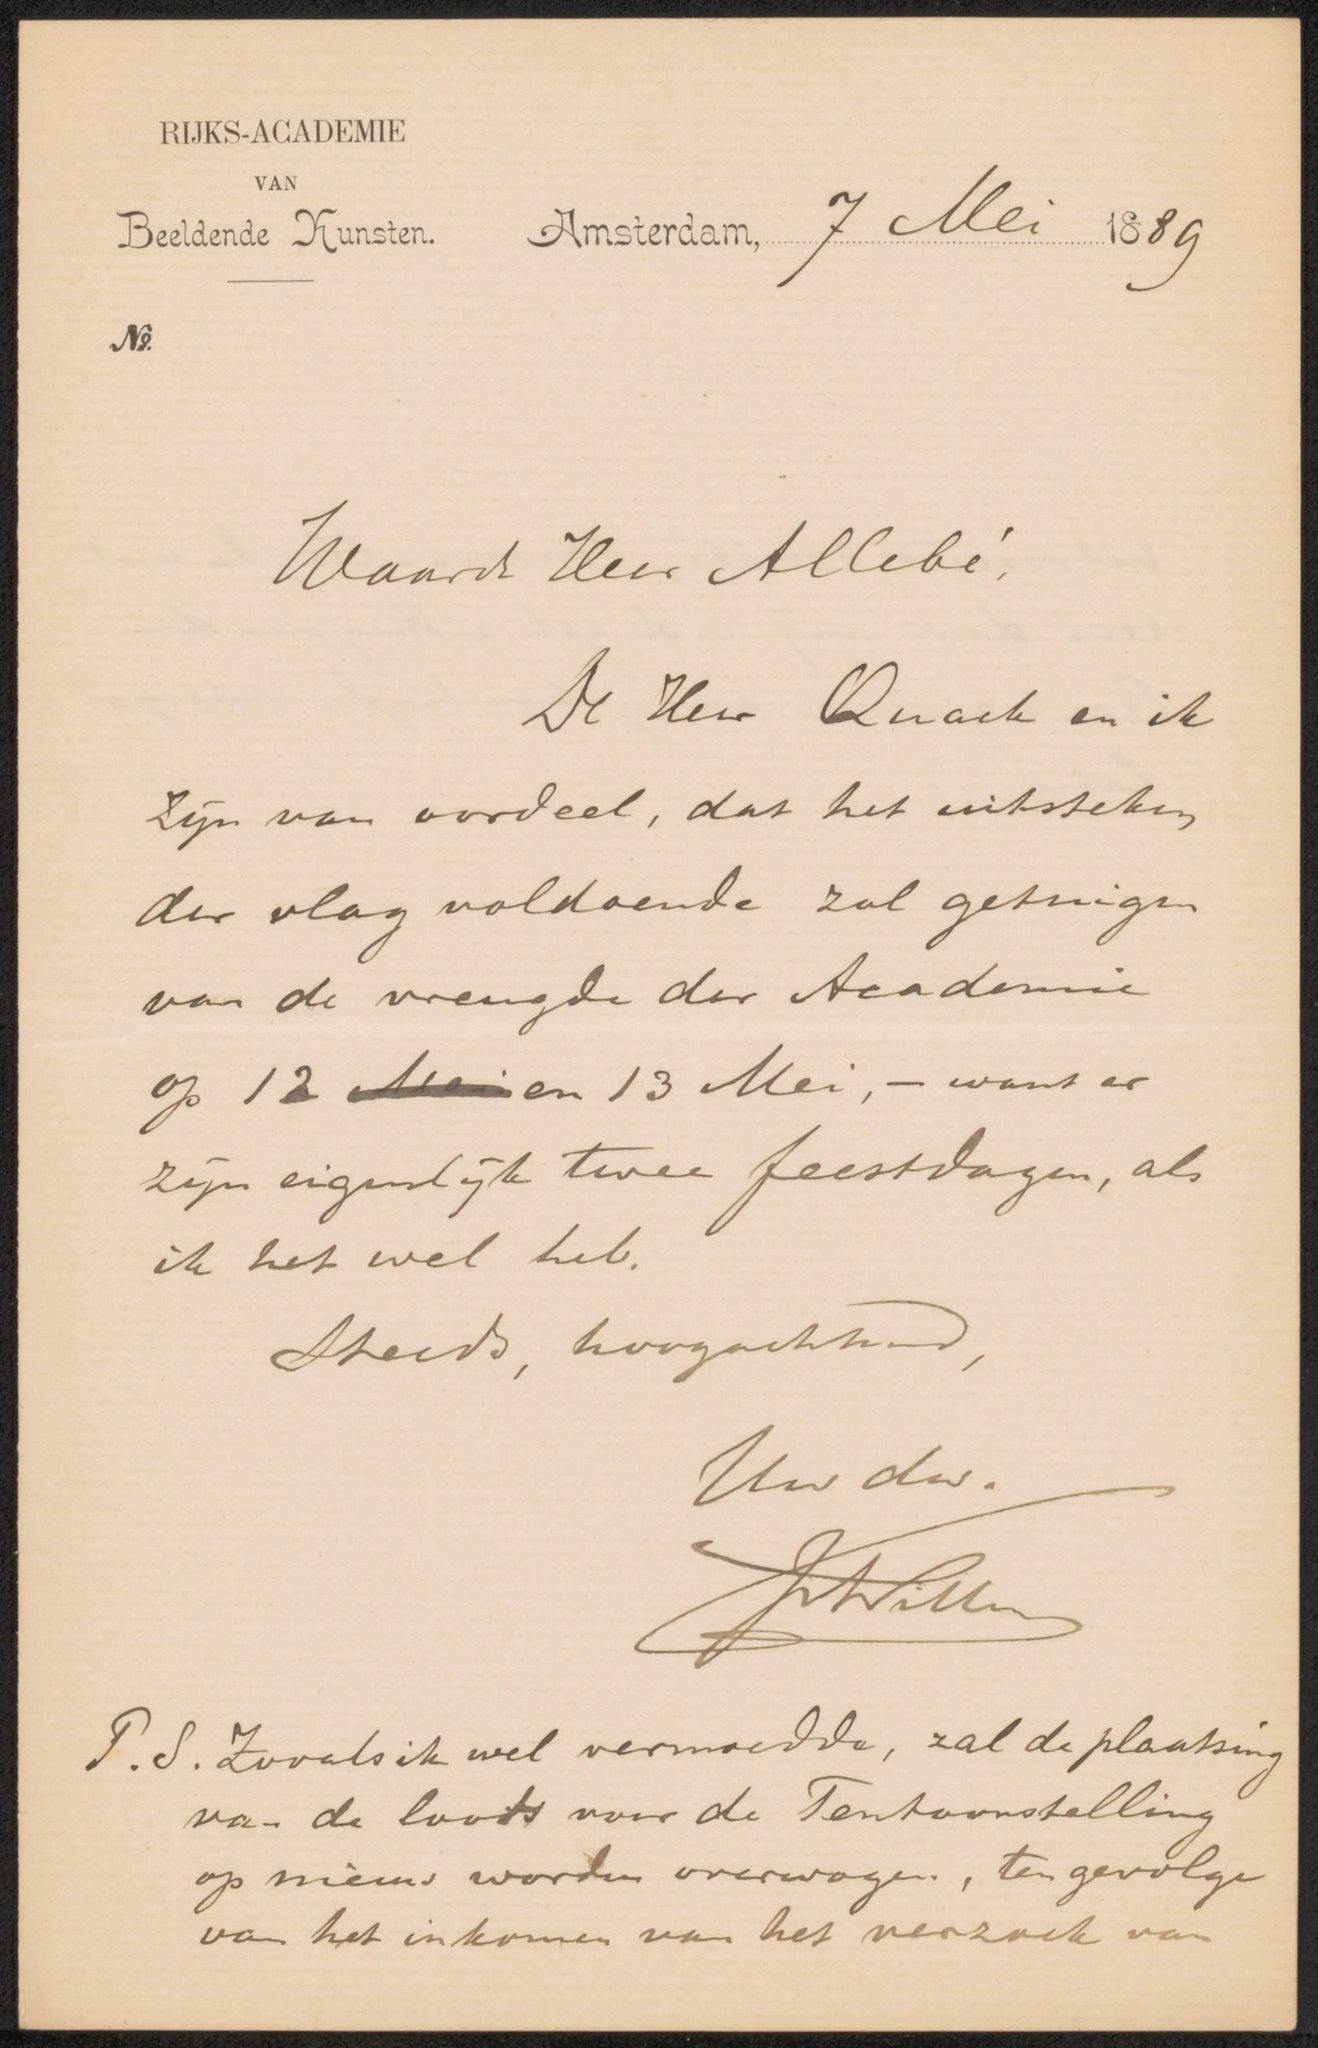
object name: letter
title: Brief aan August Allebé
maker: jérôme alexander sillem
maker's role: politician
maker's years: 1840-1912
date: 1889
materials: ink, paper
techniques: pen, printing, writing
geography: amsterdam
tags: amsterdam, print maker, draughtsman, august allebé, hendrick peter godfried quack, exhibition ~ art